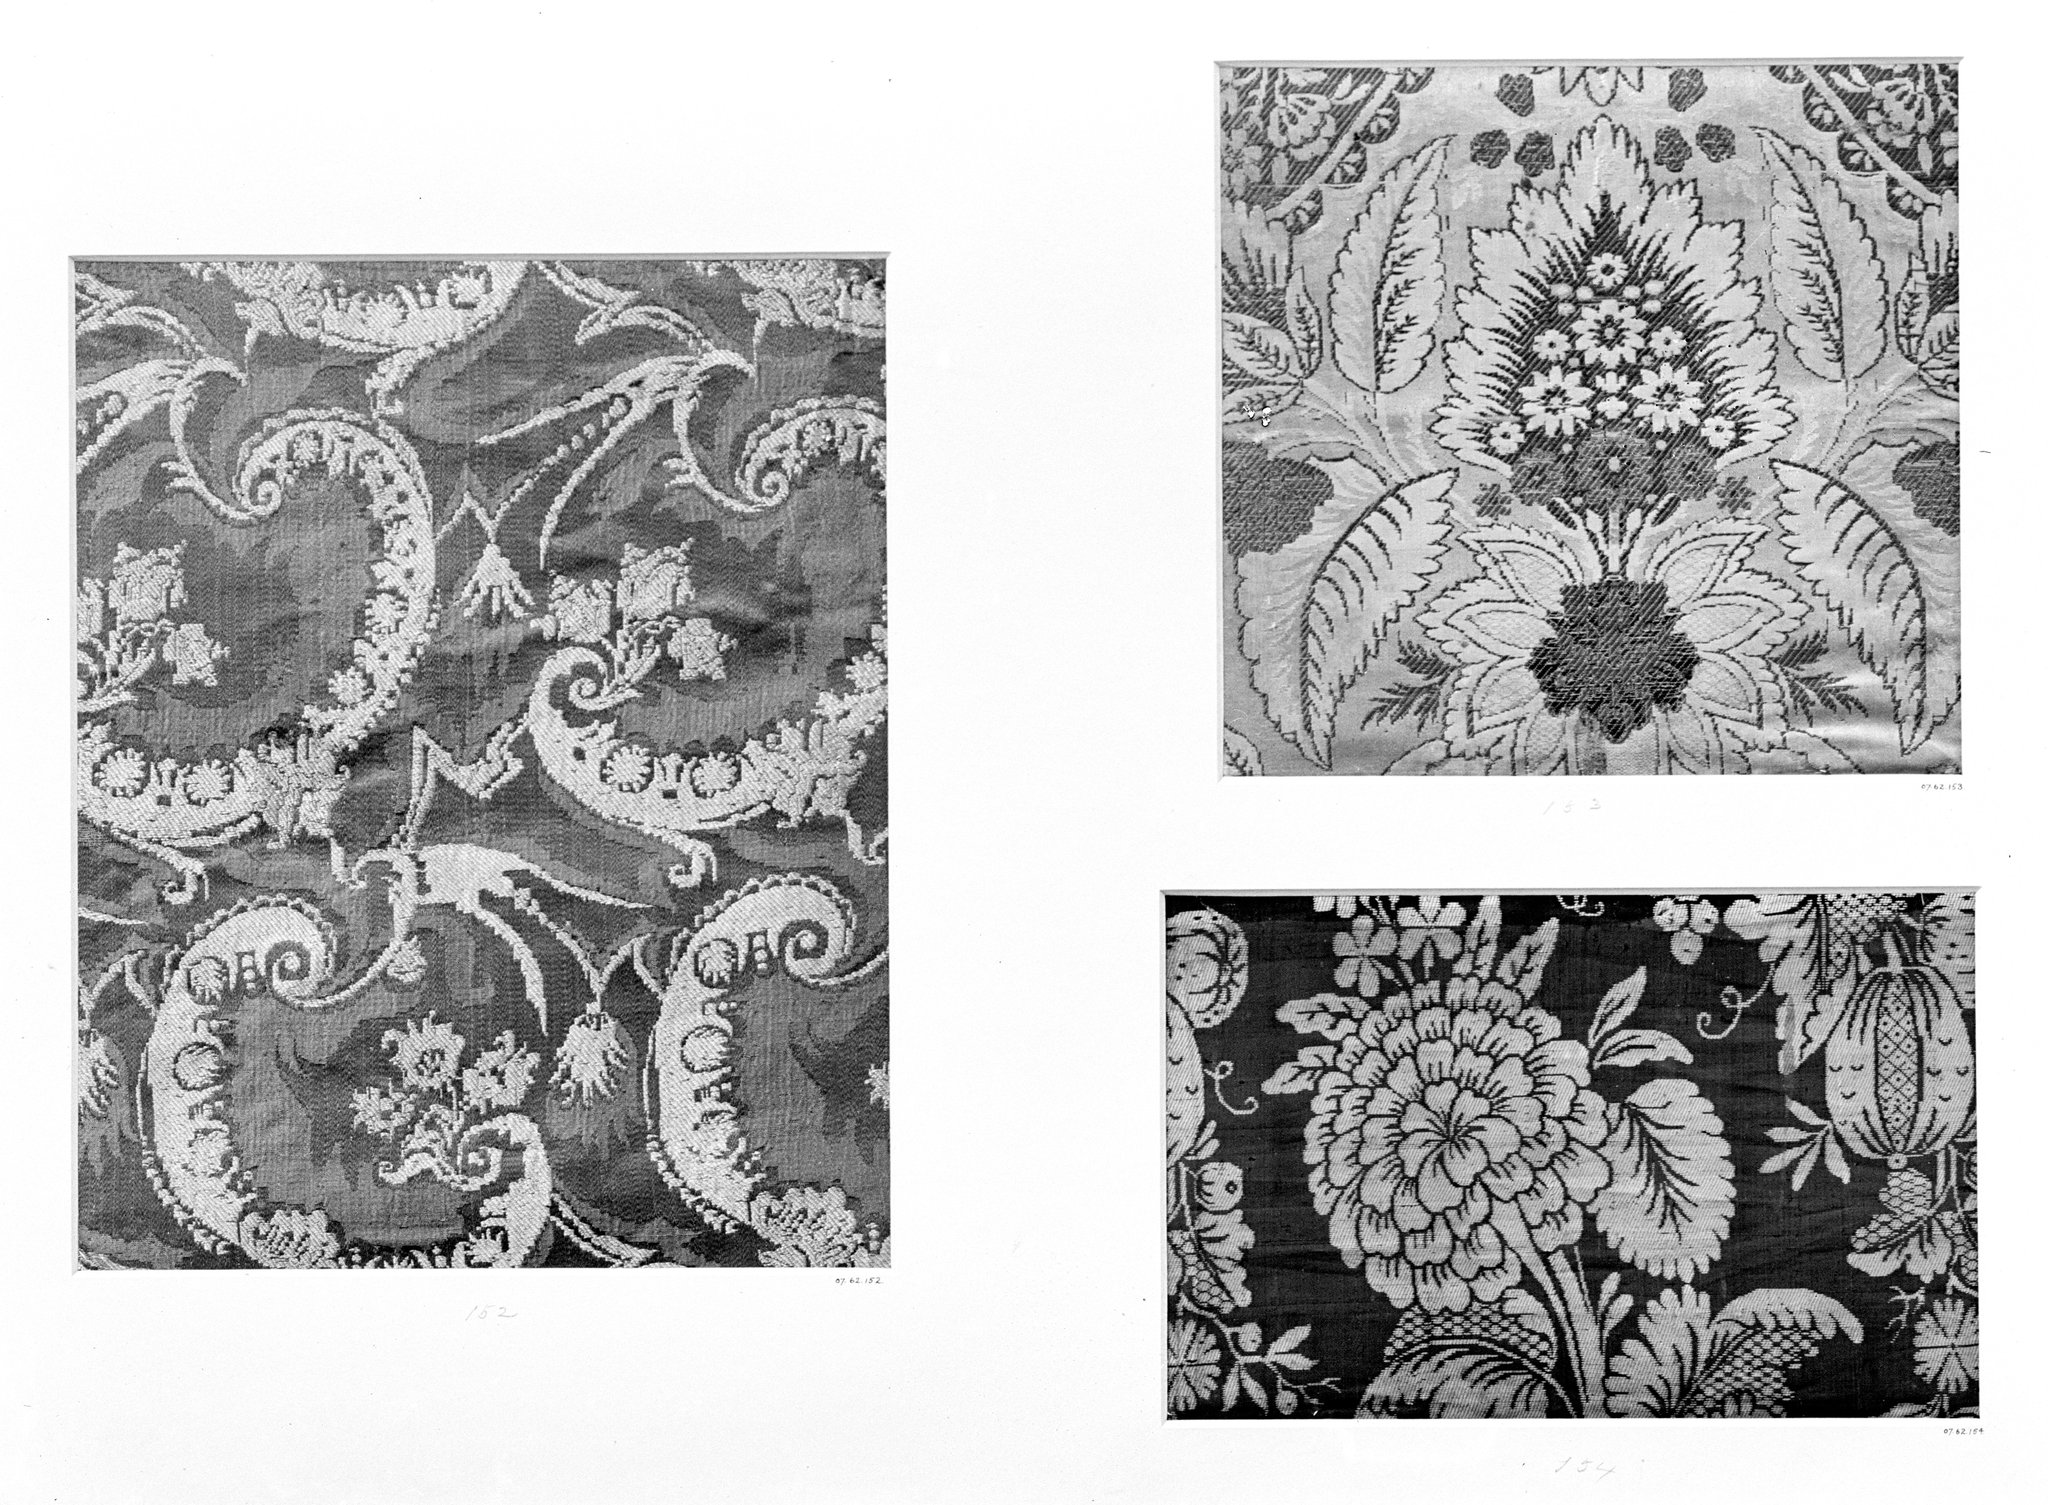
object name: piece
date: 1695-1700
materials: silk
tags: flowers,leaves